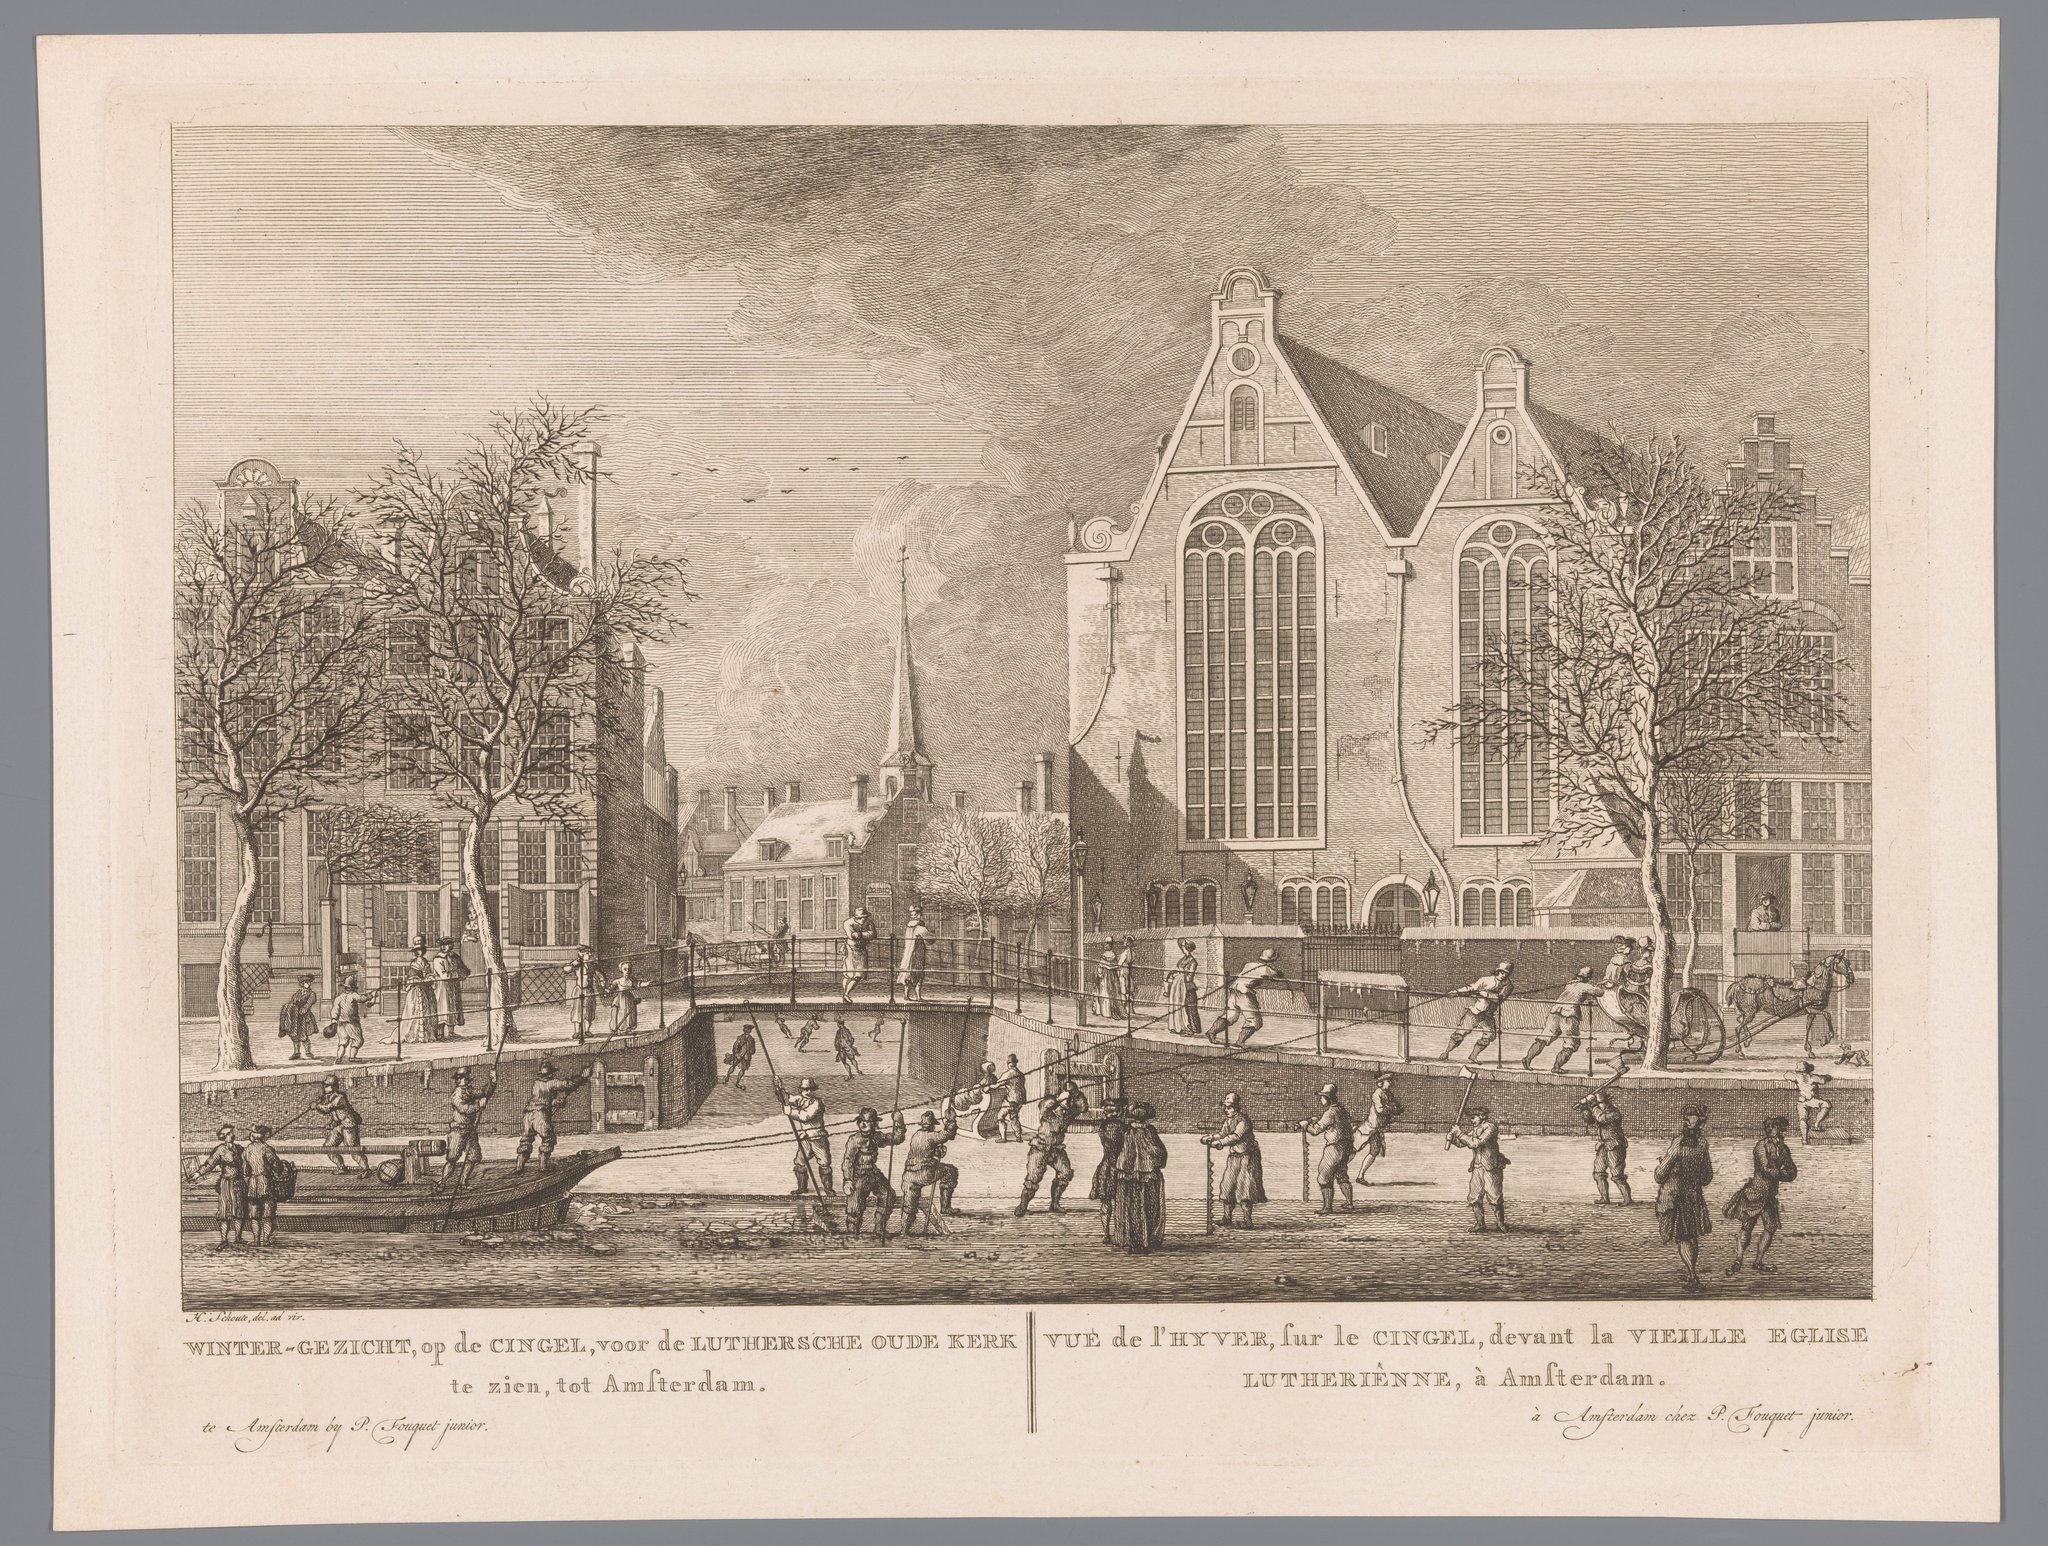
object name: print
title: Winter-Gezicht, op de Cingel, voor de Luthersche Oude Kerk te zien, tot Amsterdam / Vue de l'hyver, sur le Cingel, devant la Vieille Eglise Lutheriênne, à Amsterdam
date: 1770-1783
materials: paper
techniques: engraving, etching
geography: amsterdam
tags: protestant churches and denominations (lutherans), horse-sleigh, winter ~ human activities (the four seasons of the year), church (exterior), skates (winter sports), tow-boat, towing-barge, canals, waters (in city), street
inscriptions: collector's mark: Lugt 2233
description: Deze prent is ook gebruikt in de zogenaamde Atlas van Fouquet.* Pierre Fouquet gaf vanaf 1760 stadsgezichten van Amsterdam - naar tekeningen van verschillende kunstenaars, gemaakt door verschillende prentmakers - uit. Deze prenten werden aanvankelijk los of in series verkocht. Zoals toen gebruikelijk kon de koper de prenten zelf laten inbinden. Hiertoe gaf Fouquet tussen 1778 en 1783 een titelblad, plattegrond en inhoudsopgave van de tot dusver 100 uitgegeven prenten uit (1). Gezien de inhoud afhankelijk was van wat de koper had verzameld verschilt de inhoud van de verschillende bewaarde Fouquetatlassen onder deze titel sterk. Ook zijn er exemplaren bekend waar tevens andere prenten aan zijn toegevoegd. Omdat er behoefte bleek aan uitleg bij de platen werd in 1783 een nieuwe versie van de atlas uitgegeven, aangevuld met tekst en twee prenten. De aangegeven volgorde veranderde maar de platen van de al eerder uitgegeven prenten bleven ongewijzigd. Deze uitgave werd in opdracht van Fouquet gedrukt bij Daniël Jean Changuion en Petrus den Hengst (2). Een tiental platen werd bijgewerkt en verscheen, met nieuw impressum, in het vervolg van Wagenaars geschiedenis van Amsterdam, uitgeven door Petrus Conradi en Folkert van der Plaats (3). Een aantal jaar na het overlijden van Fouquet kwam Evert Maaskamp met een nieuwe uitgave van de atlas, met verbeterde tekst en toevoeging van twee prenten. Op alle platen verwijderde hij het oude en liet hij zijn eigen impressum zetten (4). De huidige staat van de prent komt voor in exemplaren van de onder (1) en (2) genoemde werken. * Onder de Atlas van Fouquet of Fouquetatlas verstaan we de hieronder vermelde publicaties (1), (2) en (4). (1). Afbeeldingen van de wyd-vermaarde koopstad Amsterdam benevens des zelvs voornaamste gebouwen en gezigten alle naar het leeven getekend / Receuil des edifices les plus considerables et des plus belles vues, de la fameuse ville d'Amsterdam, dessinées d'après nature. Amsterdam: Pierre Fouquet, 1778-1783. (2). Nieuwe atlas, van de voornaamste gebouwen en gezigten der stad Amsterdam, met derzelver beknopte beschryvingen. 2 dln. Amsterdam: Daniël Jean Changuion en Petrus den Hengst [in opdracht van Pierre Fouquet], 1783. (3). Stijl, Simon. Amsterdam, in zyne geschiedenissen, voorregten, koophandel, gebouwen, kerkenstaat, schoolen, schutterye, gilden en regeeringe, beschreeven. Om te dienen ten vervolge op het werk van Jan Wagenaar (…). 10 dln. Amsterdam en Harlingen: Petrus Conradi en Folkert van der Plaats, 1788-1801. (4). Nieuwe atlas, van de voornaamste gebouwen en gezigten der stad Amsterdam. Met derzelver beknopte beschryvingen. Amsterdam: Evert Maaskamp, 1805. * Het aantal vermelde staten is gebaseerd op het aantal gevonden staten. Mogelijk zijn er meer staten van deze prent. Zie RP-P-AO-24-1AX voor latere staat.